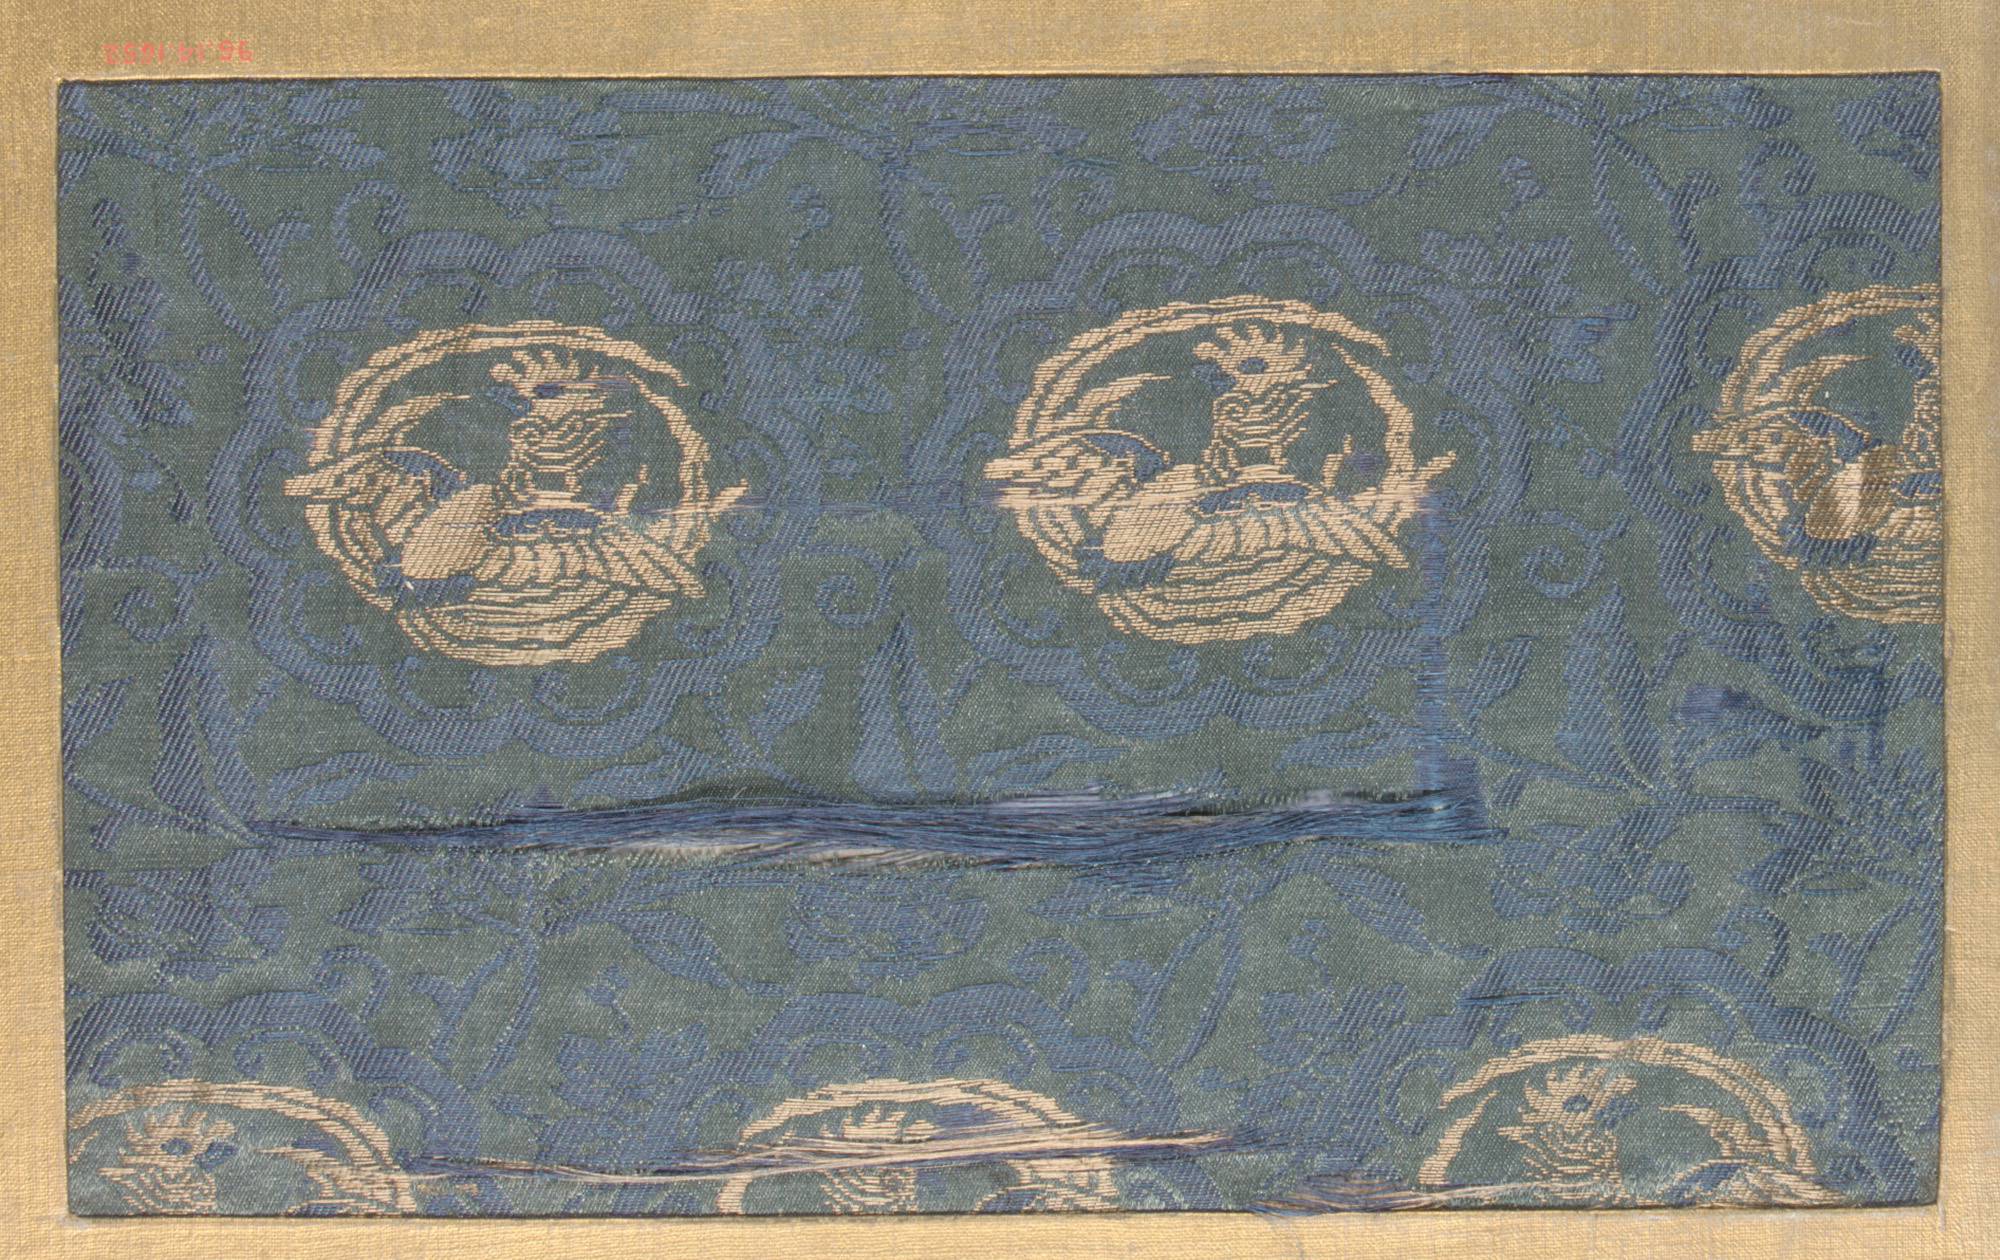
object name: piece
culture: japanese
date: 1701-1900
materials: silk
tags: birds